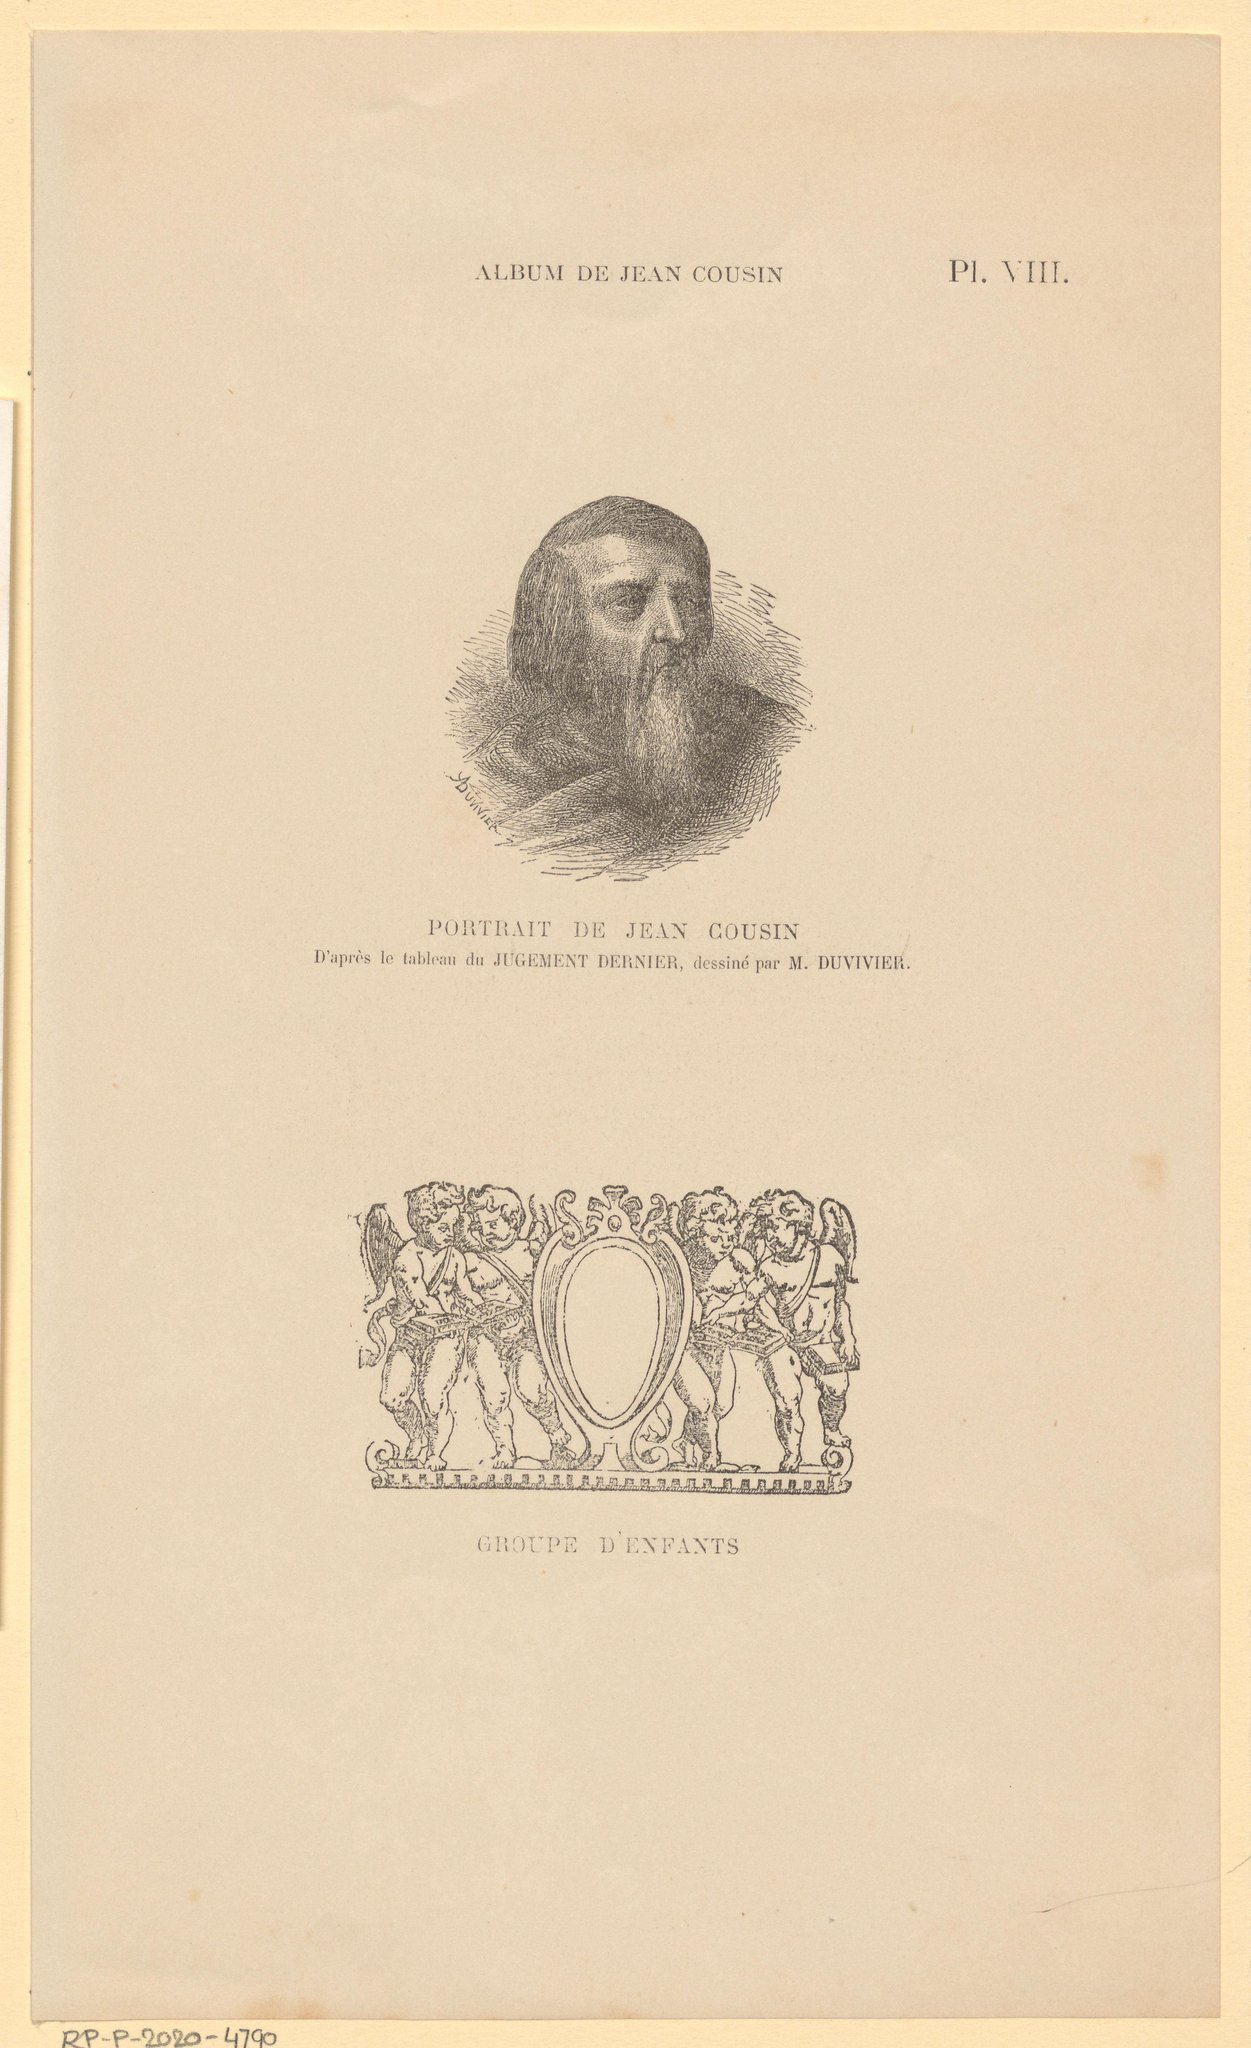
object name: print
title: Portret van Jean Cousin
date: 1800-1849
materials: paper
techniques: letterpress printing, engraving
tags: france, painter, print maker, jean cousin, portrait, self-portrait of painter